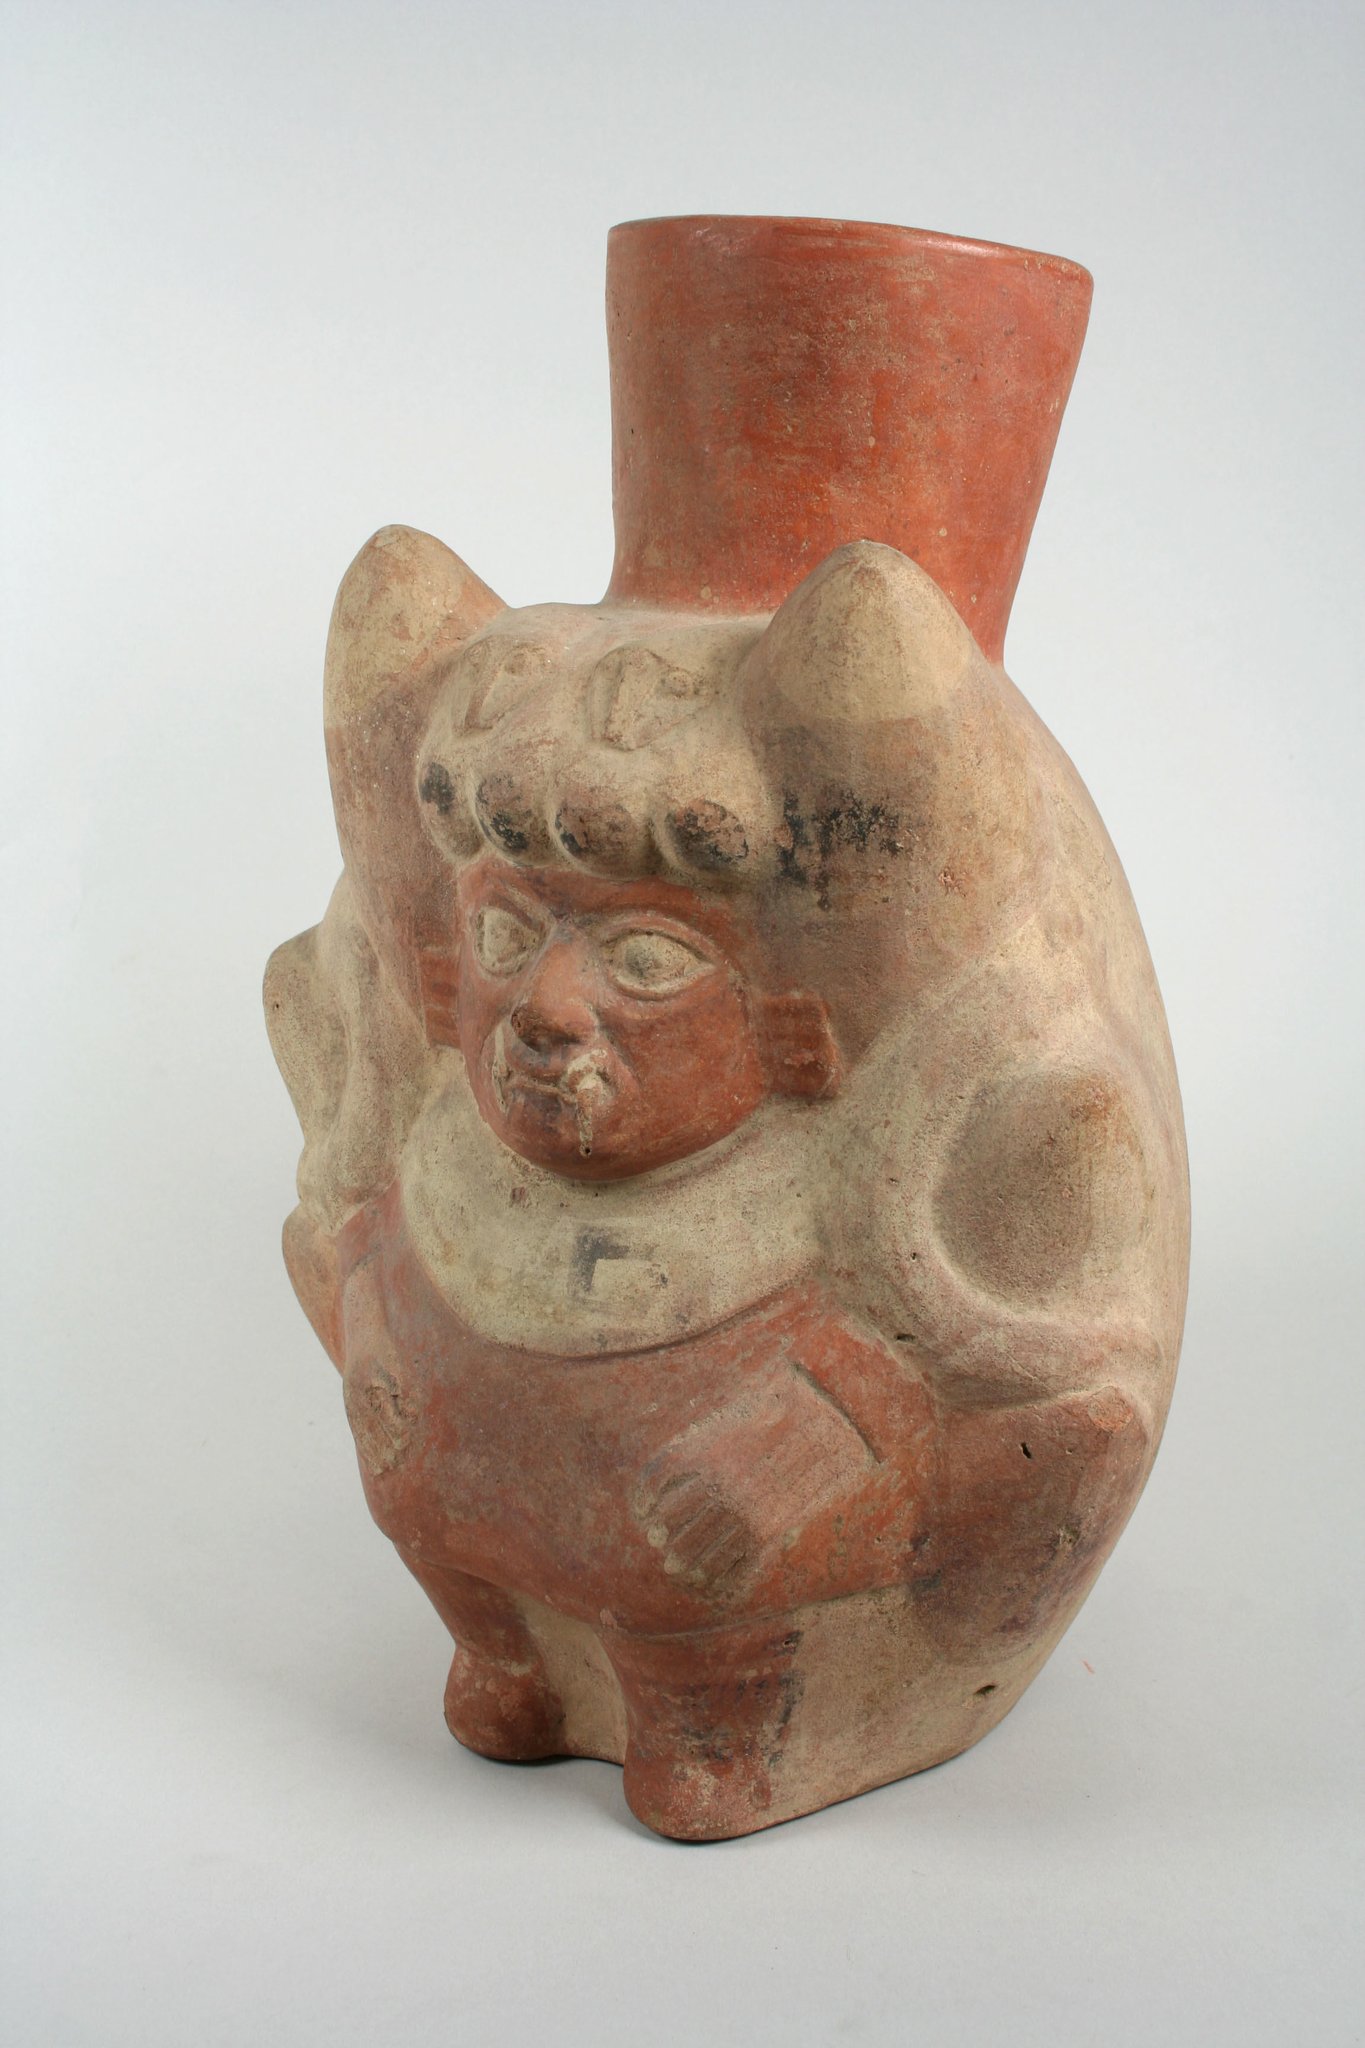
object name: jar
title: Bottle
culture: moche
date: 101-500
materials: ceramic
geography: peru